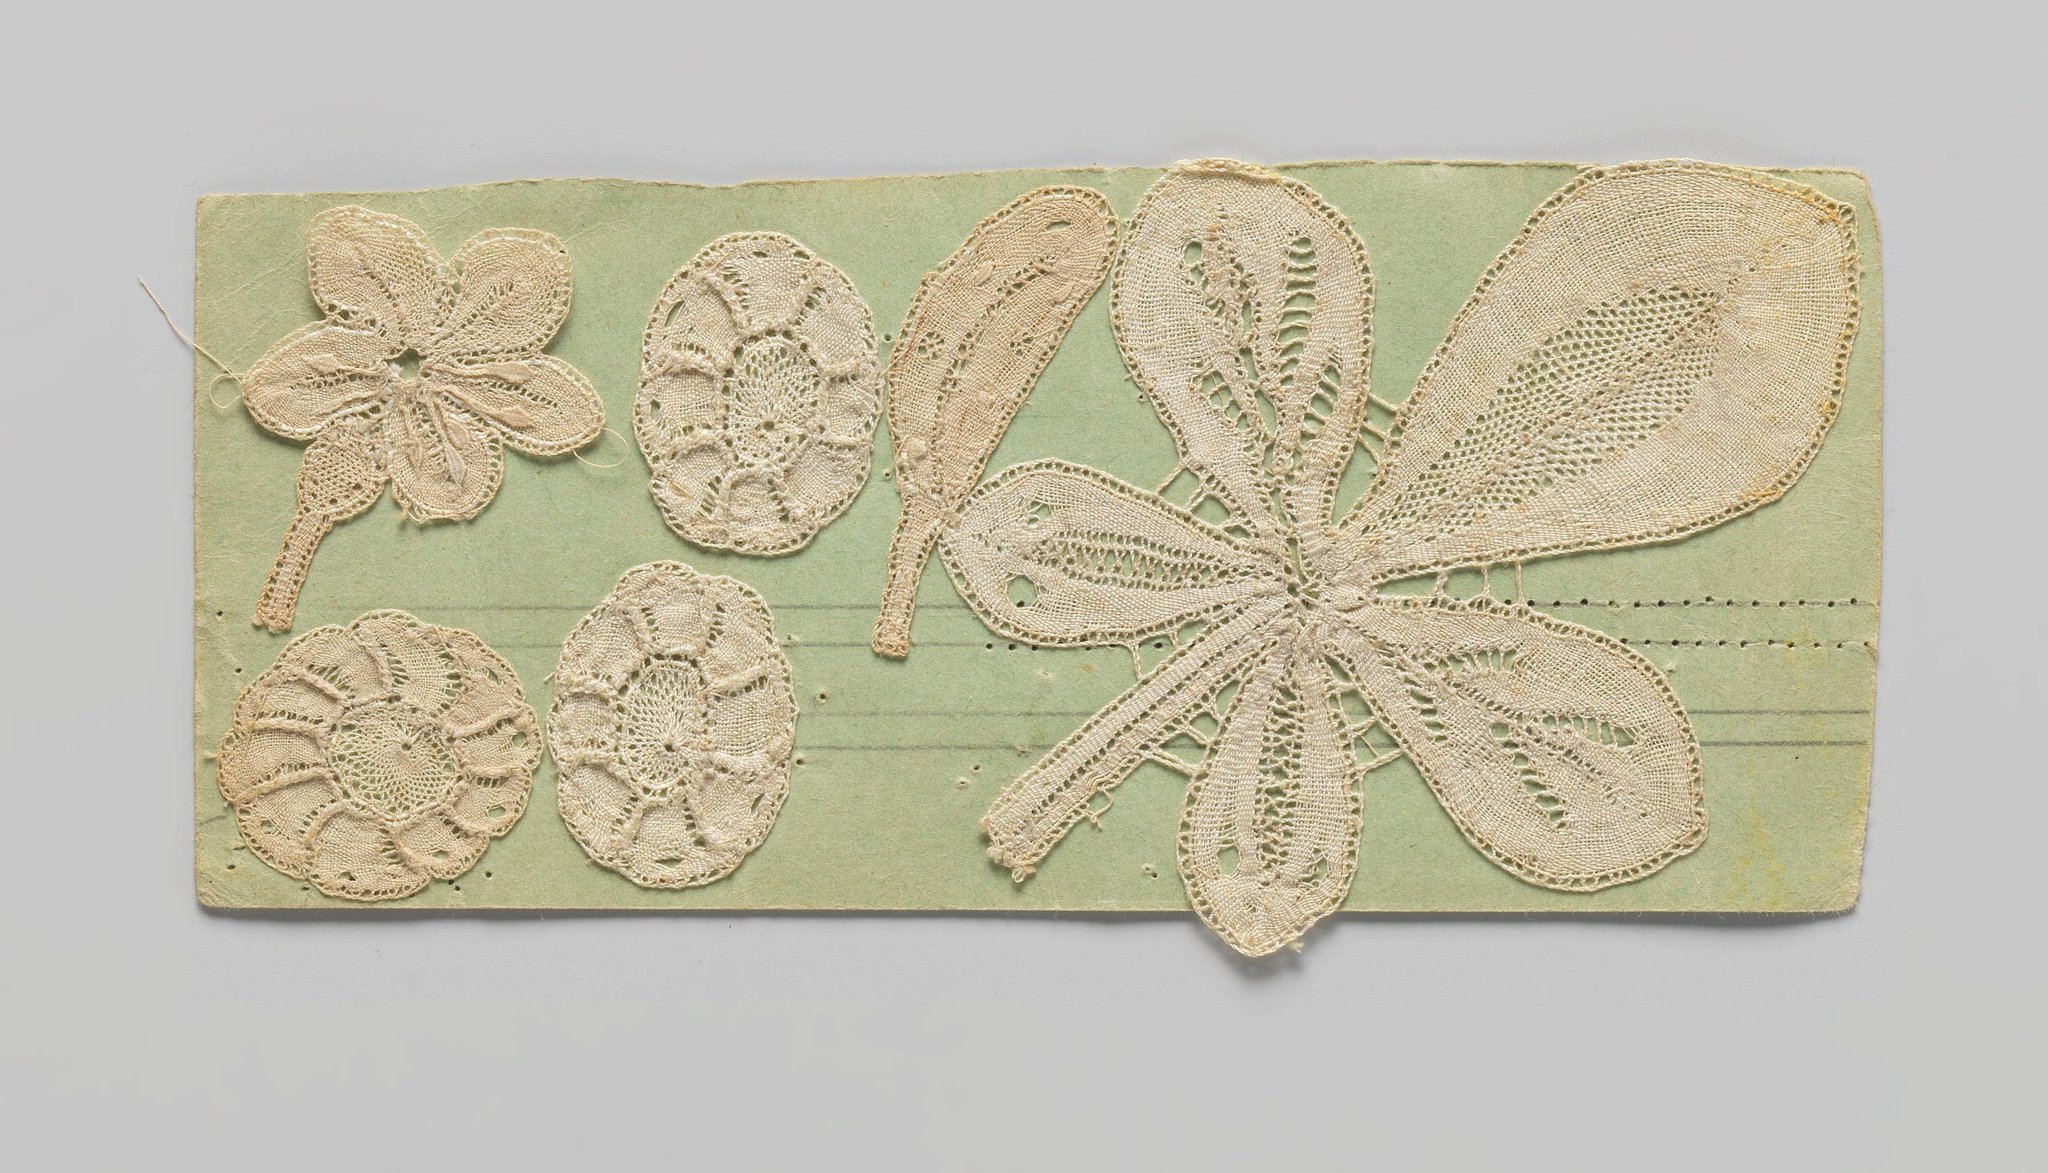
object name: motif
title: Proefmotieven van kloskant voor een kleedrand met een dessin van paardekastanjes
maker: louise wilhelmina van der meulen-nulle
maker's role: docent, kantwerkster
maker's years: 1884-1982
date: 1912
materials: cardboard, linen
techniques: lace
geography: apeldoorn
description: Proefmotiefjes van naturelkleurig kloskant - duchesse-kant - behorende bij een patroon voor een kleedrand in kloskant met een dessin van paardekastanjes. De motiefjes zijn op een rechthoekig stuk lichtgroen gekleurd karton bevestigd. Het gaat om zes losse motiefjes: een bloem op een steel, drie ovale bloemen, een blad of deel van een kastanje (?) en een kastanjeblad. Ze zijn geklost in netslag en linnenslag met opengewerkte randjes en uitsparingen. Ze zijn deels voorzien van reliëfcontouren en contouren gemaakt met een glimmende draad.